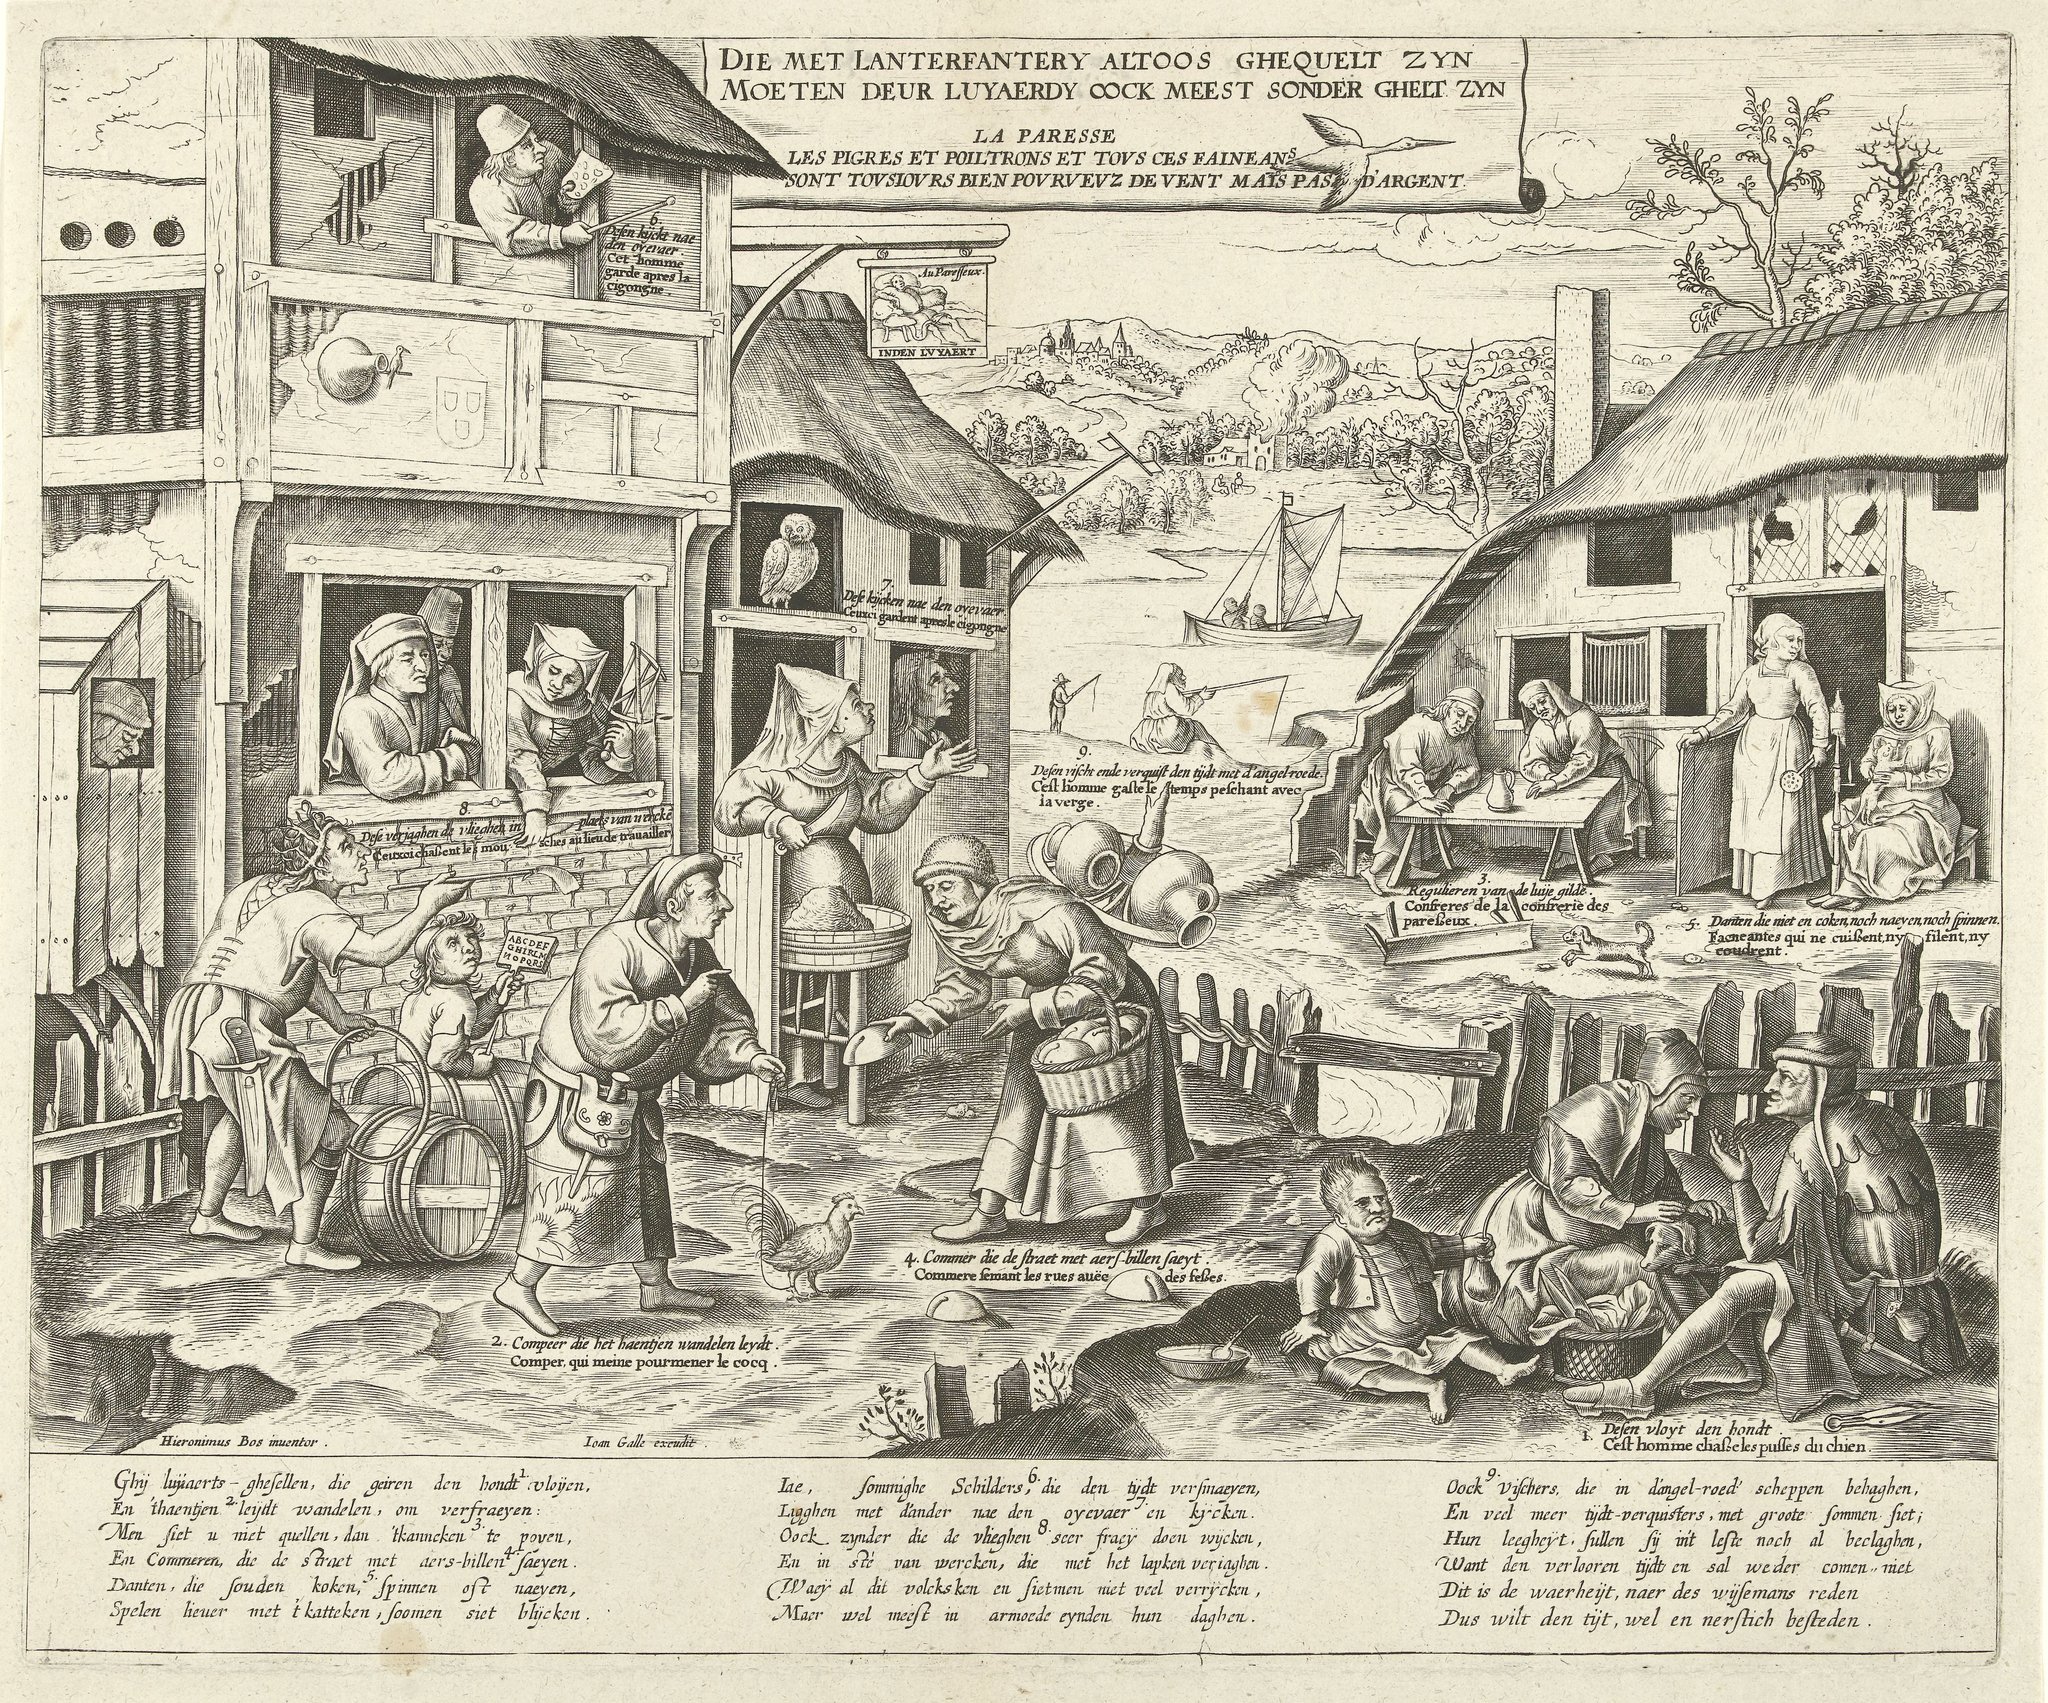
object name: print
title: Die met lanterfantery altoos ghequelt zyn moeten deur luyaerdy oock meest sonder ghelt zyn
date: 1546-1562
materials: paper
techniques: engraving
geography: antwerp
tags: sluggishness, inertia; 'dapocaggine', 'pigritia' (ripa), proverbs, sayings, etc., sluggard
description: Dorp met de uitbeelding van Vlaamse spreekwoorden over de luiheid. Links een huis met daarop het wapen van het Sint Lucasgilde. In het raam mensen, die vliegen verjagen. In het bovenste raam een schilder met schilderstok en palet, die naar de ooievaar kijkt. Bij een herberg een man en een vrouw, die eveneens naar de ooievaar kijken. Op de voorgrond een man, die met een haan aan het wandelen is. Een vrouw zaait de straat met aarsbillen, wat wil zeggen dat ze langs de straat slentert. Rechts op de voorgrond een vrouw, die de hond vlooit. Rechtsachter een vrouw, die met een kat speelt achter een spinnenwiel en een vrouw met een lepel voor een woning. Een man en een vrouw aan een tafel worden aangeduid als de regulieren van het luie gilde. Op de achtergrond vissers aan het water. Toelichtende teksten in de voorstelling in het Nederlands en Frans. Onder drie verzen in het Nederlands.